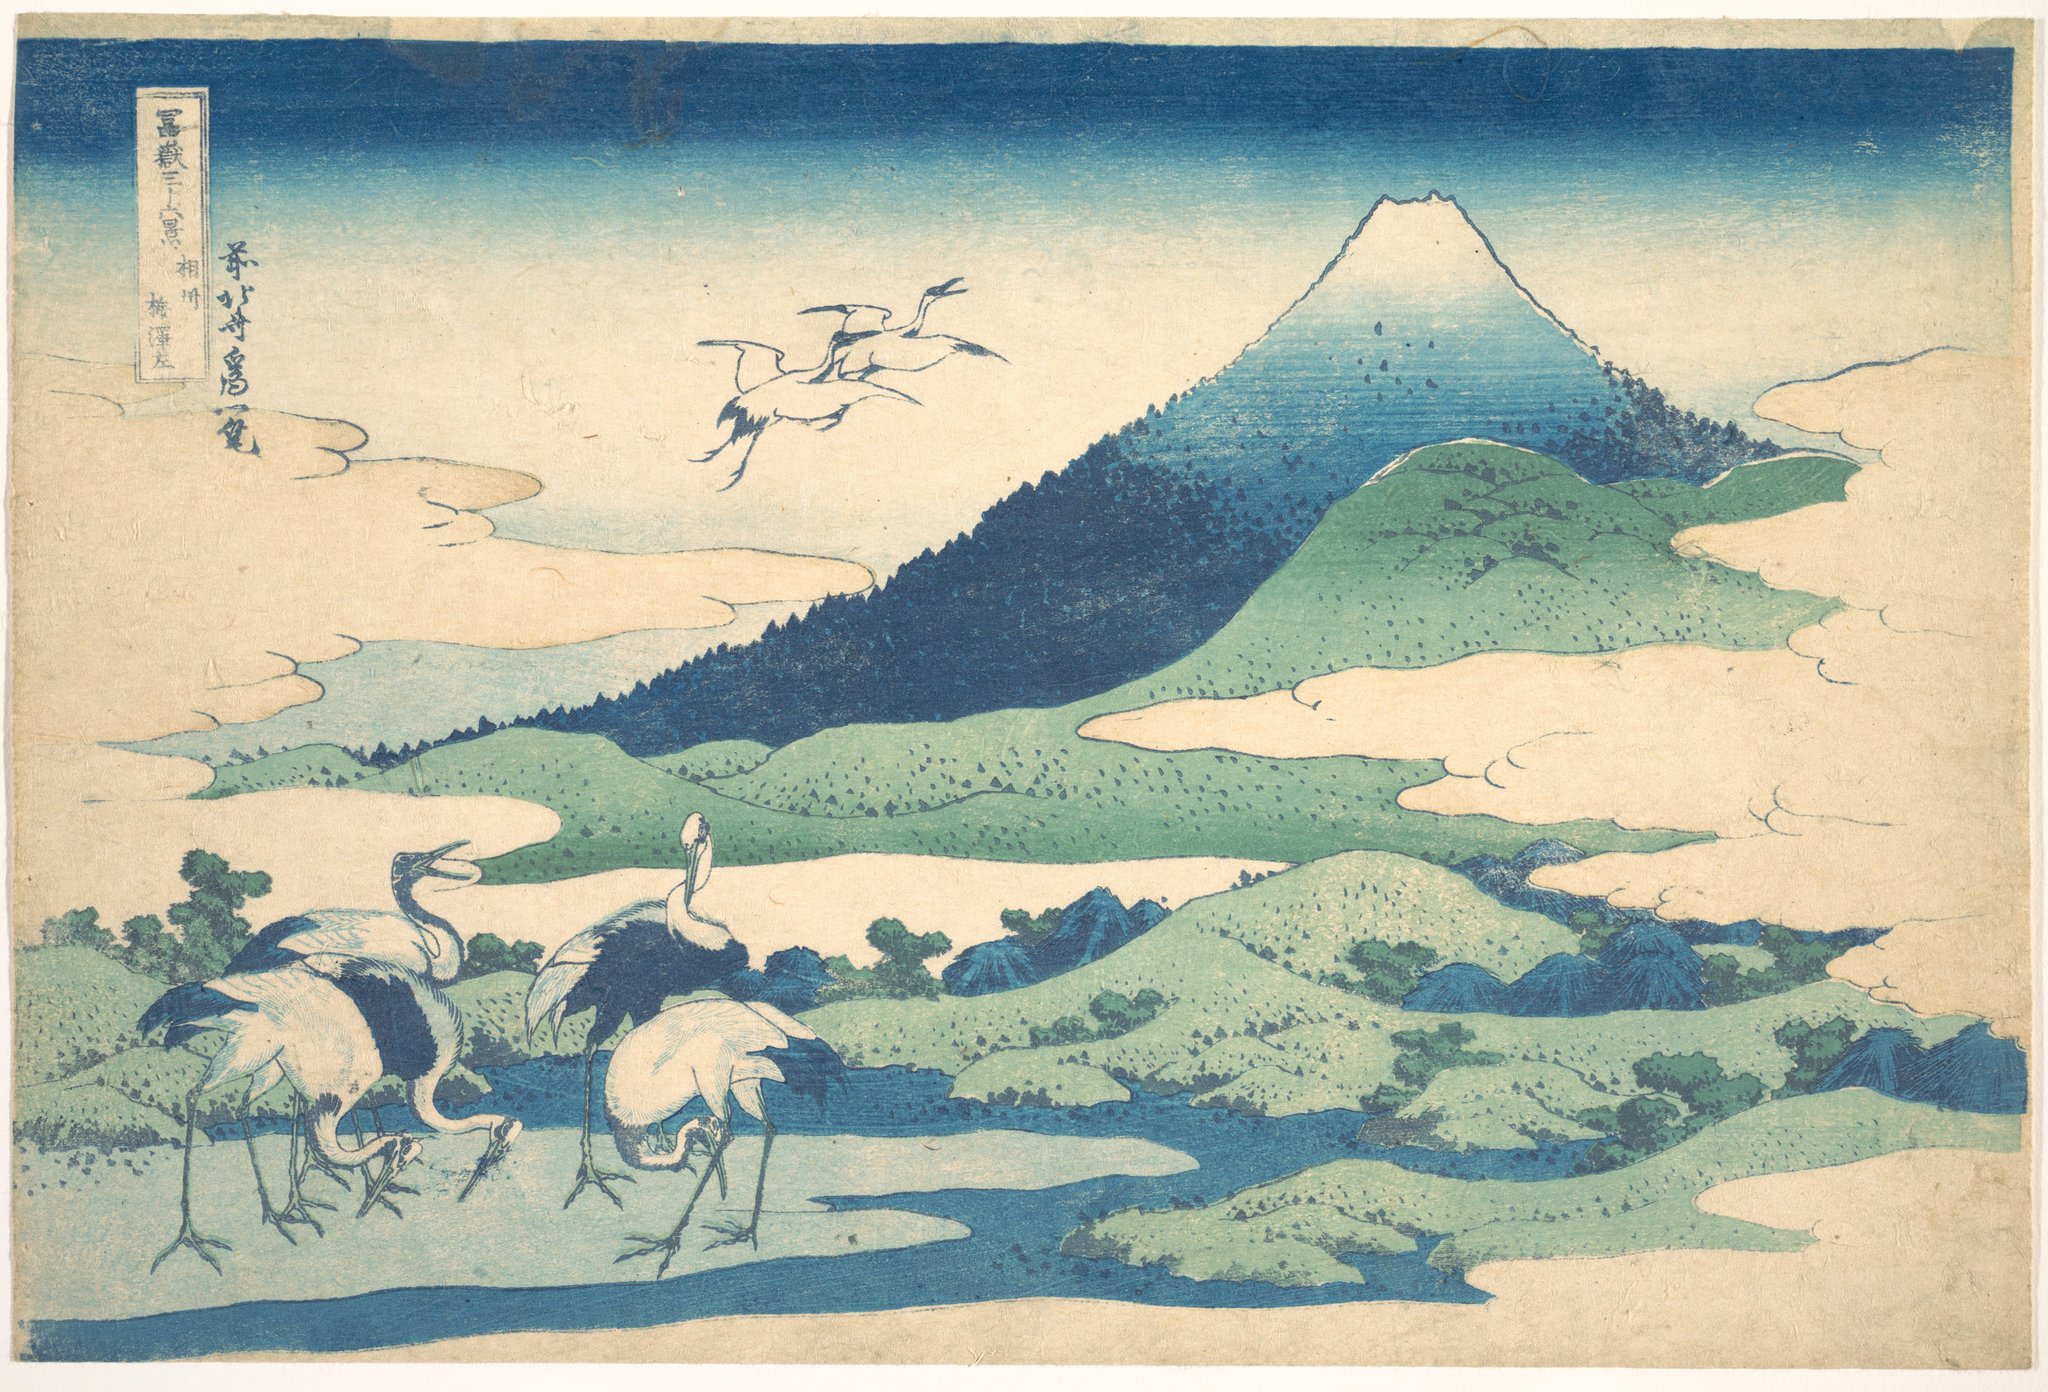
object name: woodblock print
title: Umezawa Manor in Sagami Province (Sōshū Umezawa zai), from the series Thirty-six Views of Mount Fuji (Fugaku sanjūrokkei)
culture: japanese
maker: katsushika hokusai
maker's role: artist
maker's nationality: japanese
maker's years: 1760-1849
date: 1830-1832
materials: ink, paper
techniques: woodblock print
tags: birds,mountains,landscapes